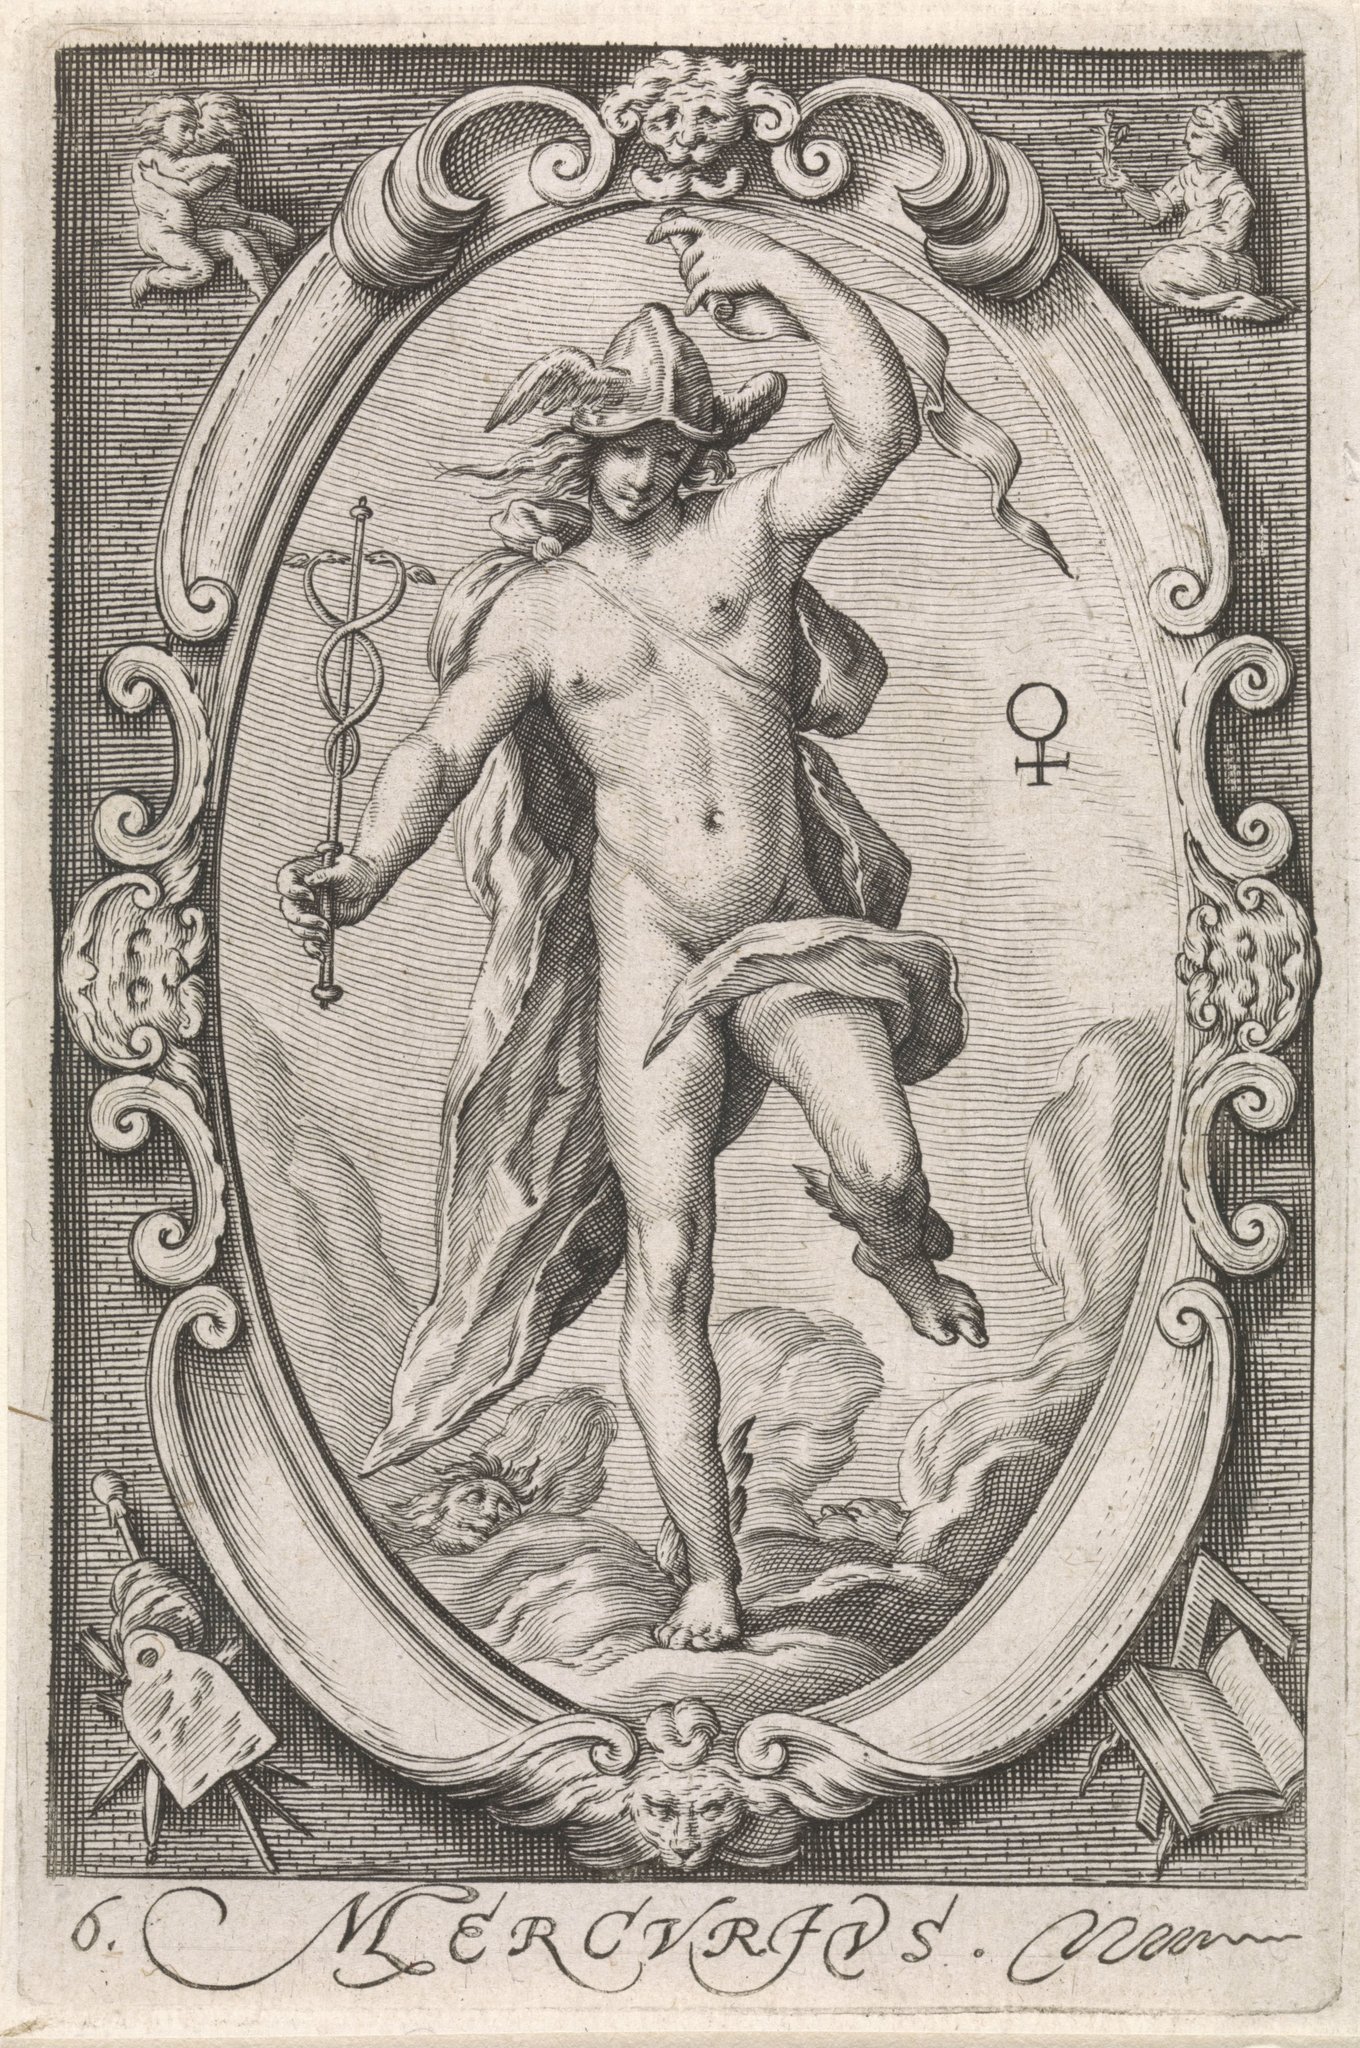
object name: print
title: Mercurius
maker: jacob matham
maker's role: draughtsman, print maker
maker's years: 1571-1631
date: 1597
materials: paper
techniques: engraving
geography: haarlem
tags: (story of) mercury (hermes), mercury (planet)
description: Mercurius, met in zijn hand een caduceus en op zijn hoofd een gevleugelde hoed (petasus). Rechts van hem het astronomische symbool voor zijn planeet. Staand in een ovaal cartouche met bovenaan de twee tekenen van de dierenriem: Tweelingen en Maagd.